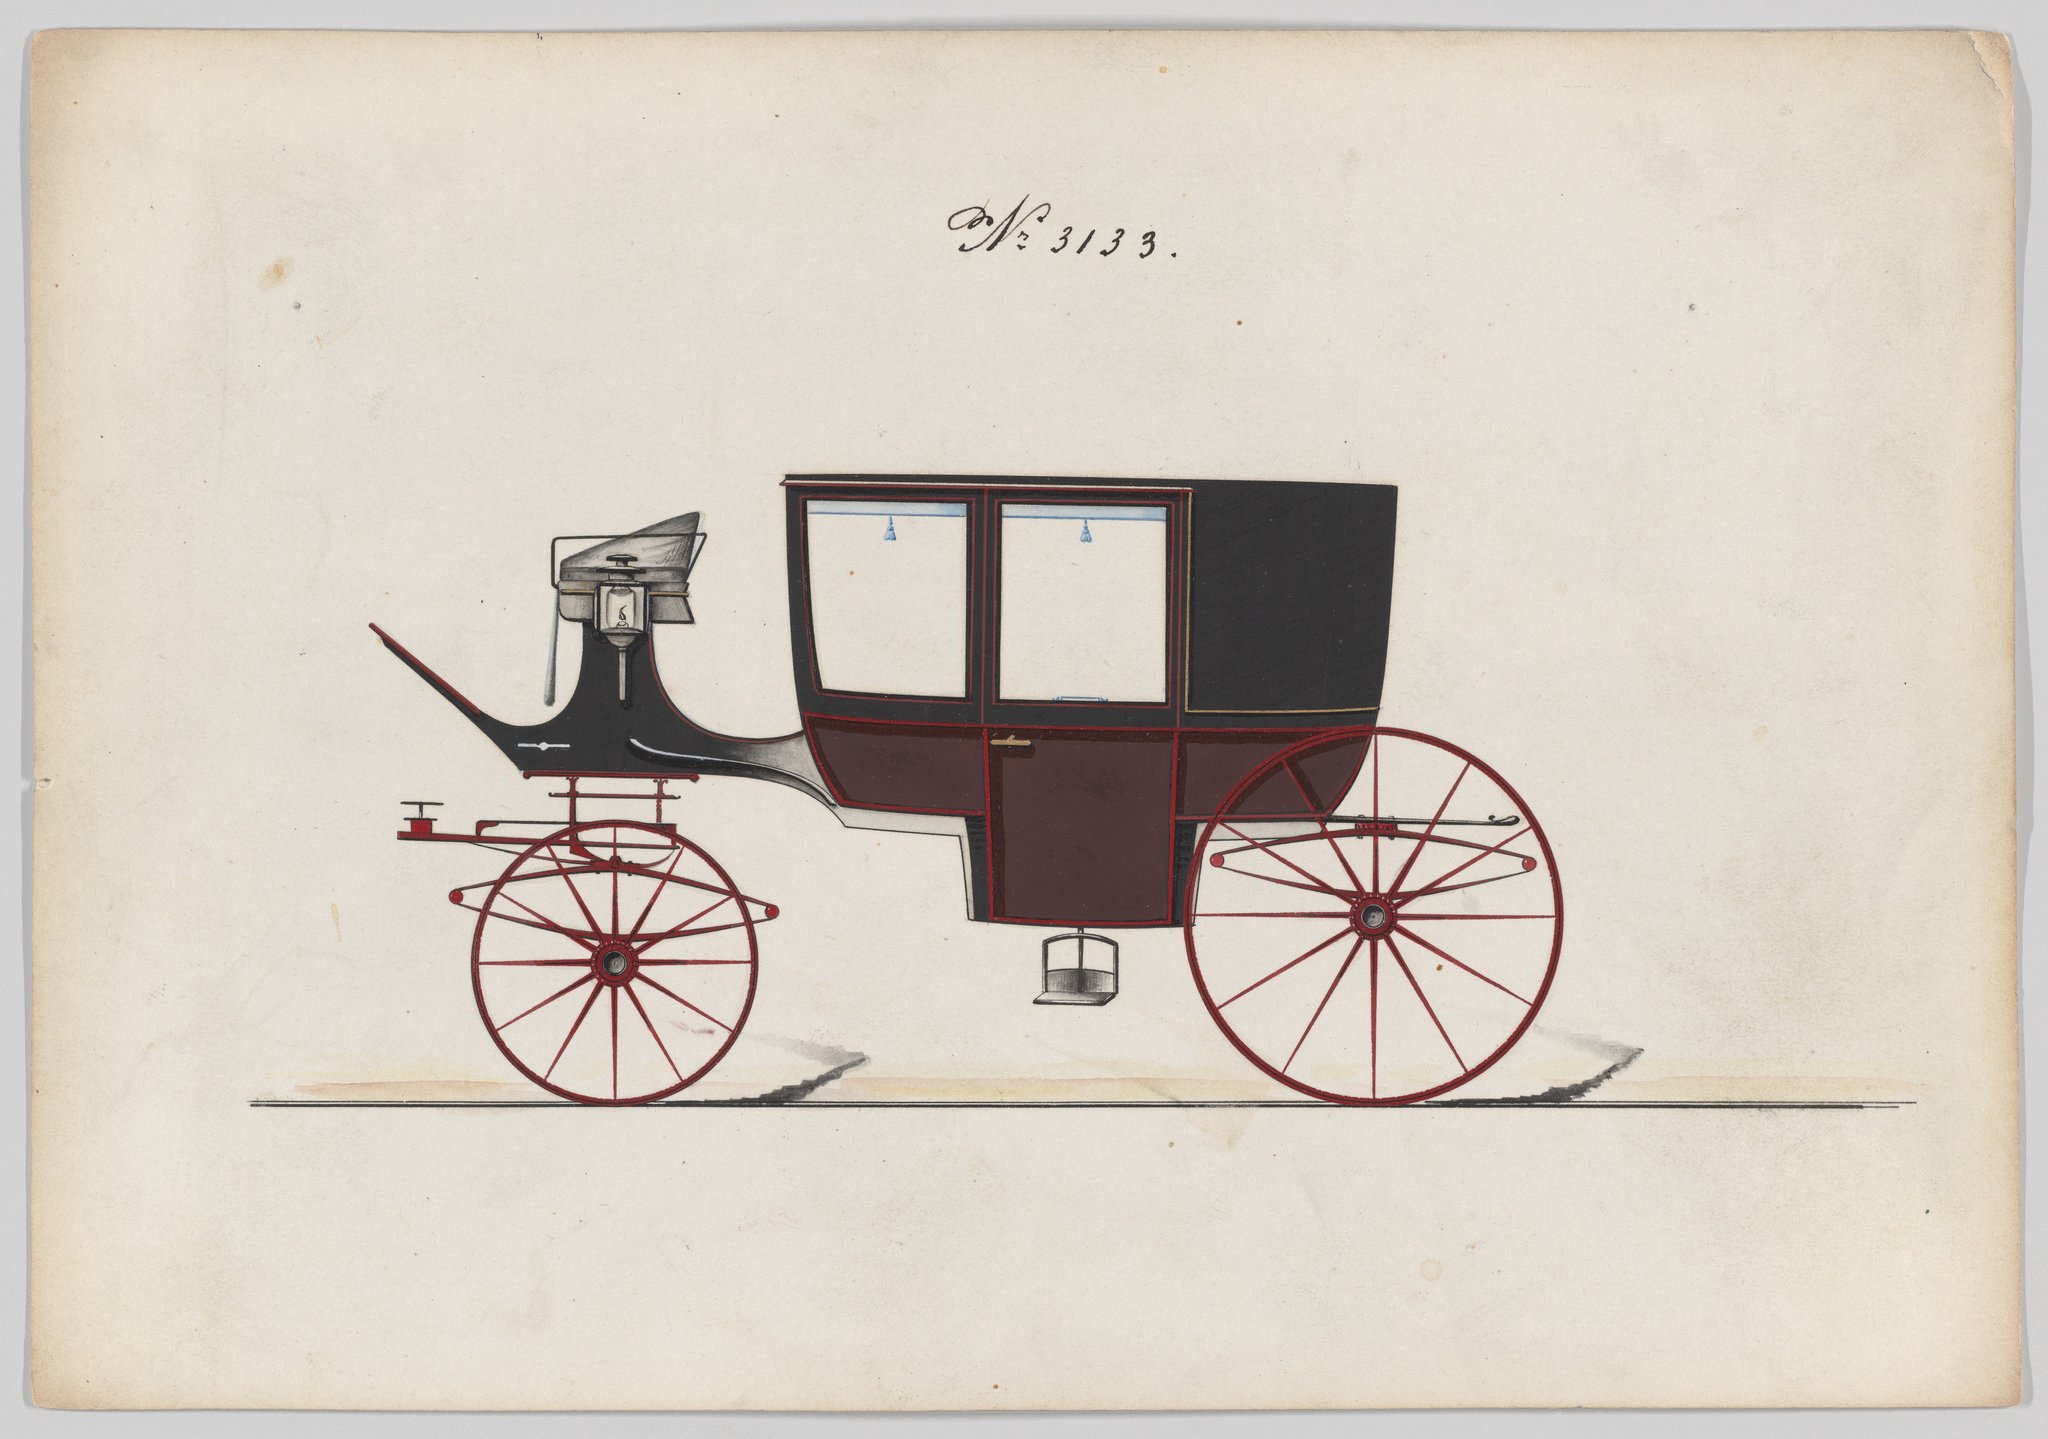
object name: drawing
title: Coach #3133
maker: brewster & co.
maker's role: manufacturer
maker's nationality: american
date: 1875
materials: gouache, gum arabic, ink, watercolor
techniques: pen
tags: carriages